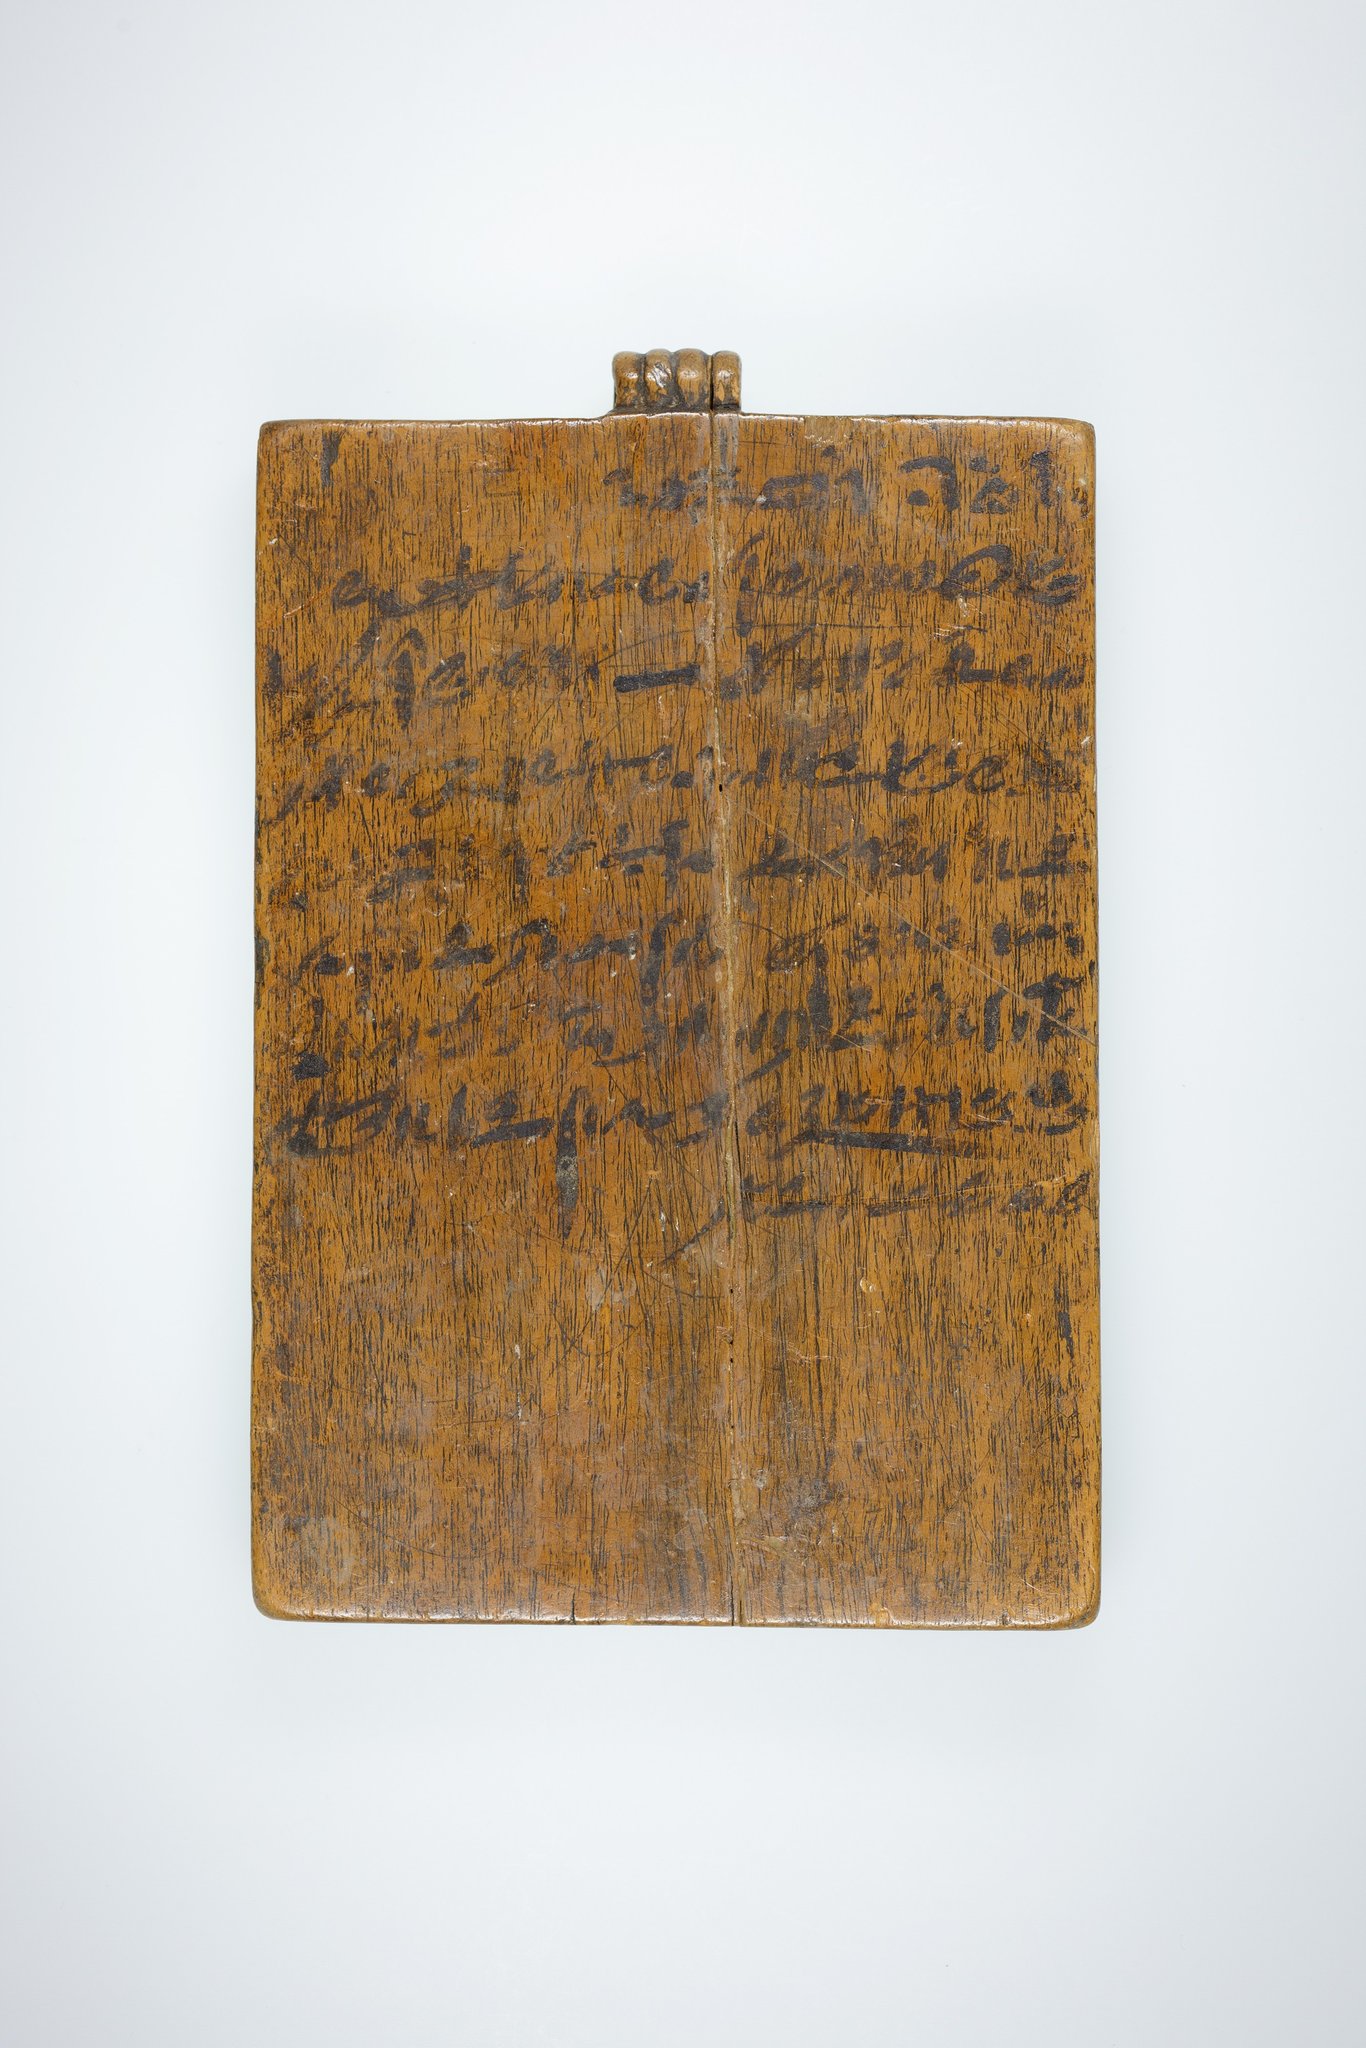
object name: scribe's tablet, writing board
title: Scribe's Tablet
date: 664-332 BCE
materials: ink, wood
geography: egypt